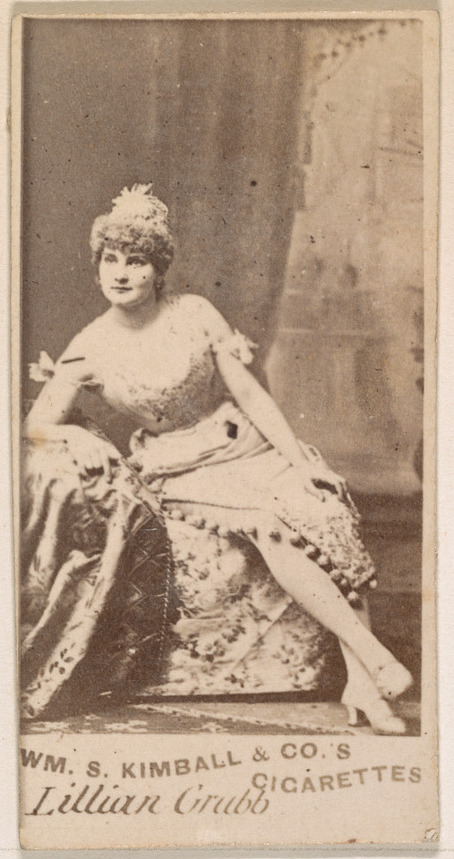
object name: photograph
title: Lillian Grubb, from the Actresses series (N203) issued by Wm. S. Kimball & Co.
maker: william s. kimball & company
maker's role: publisher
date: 1889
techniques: color lithograph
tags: portraits,women,actresses